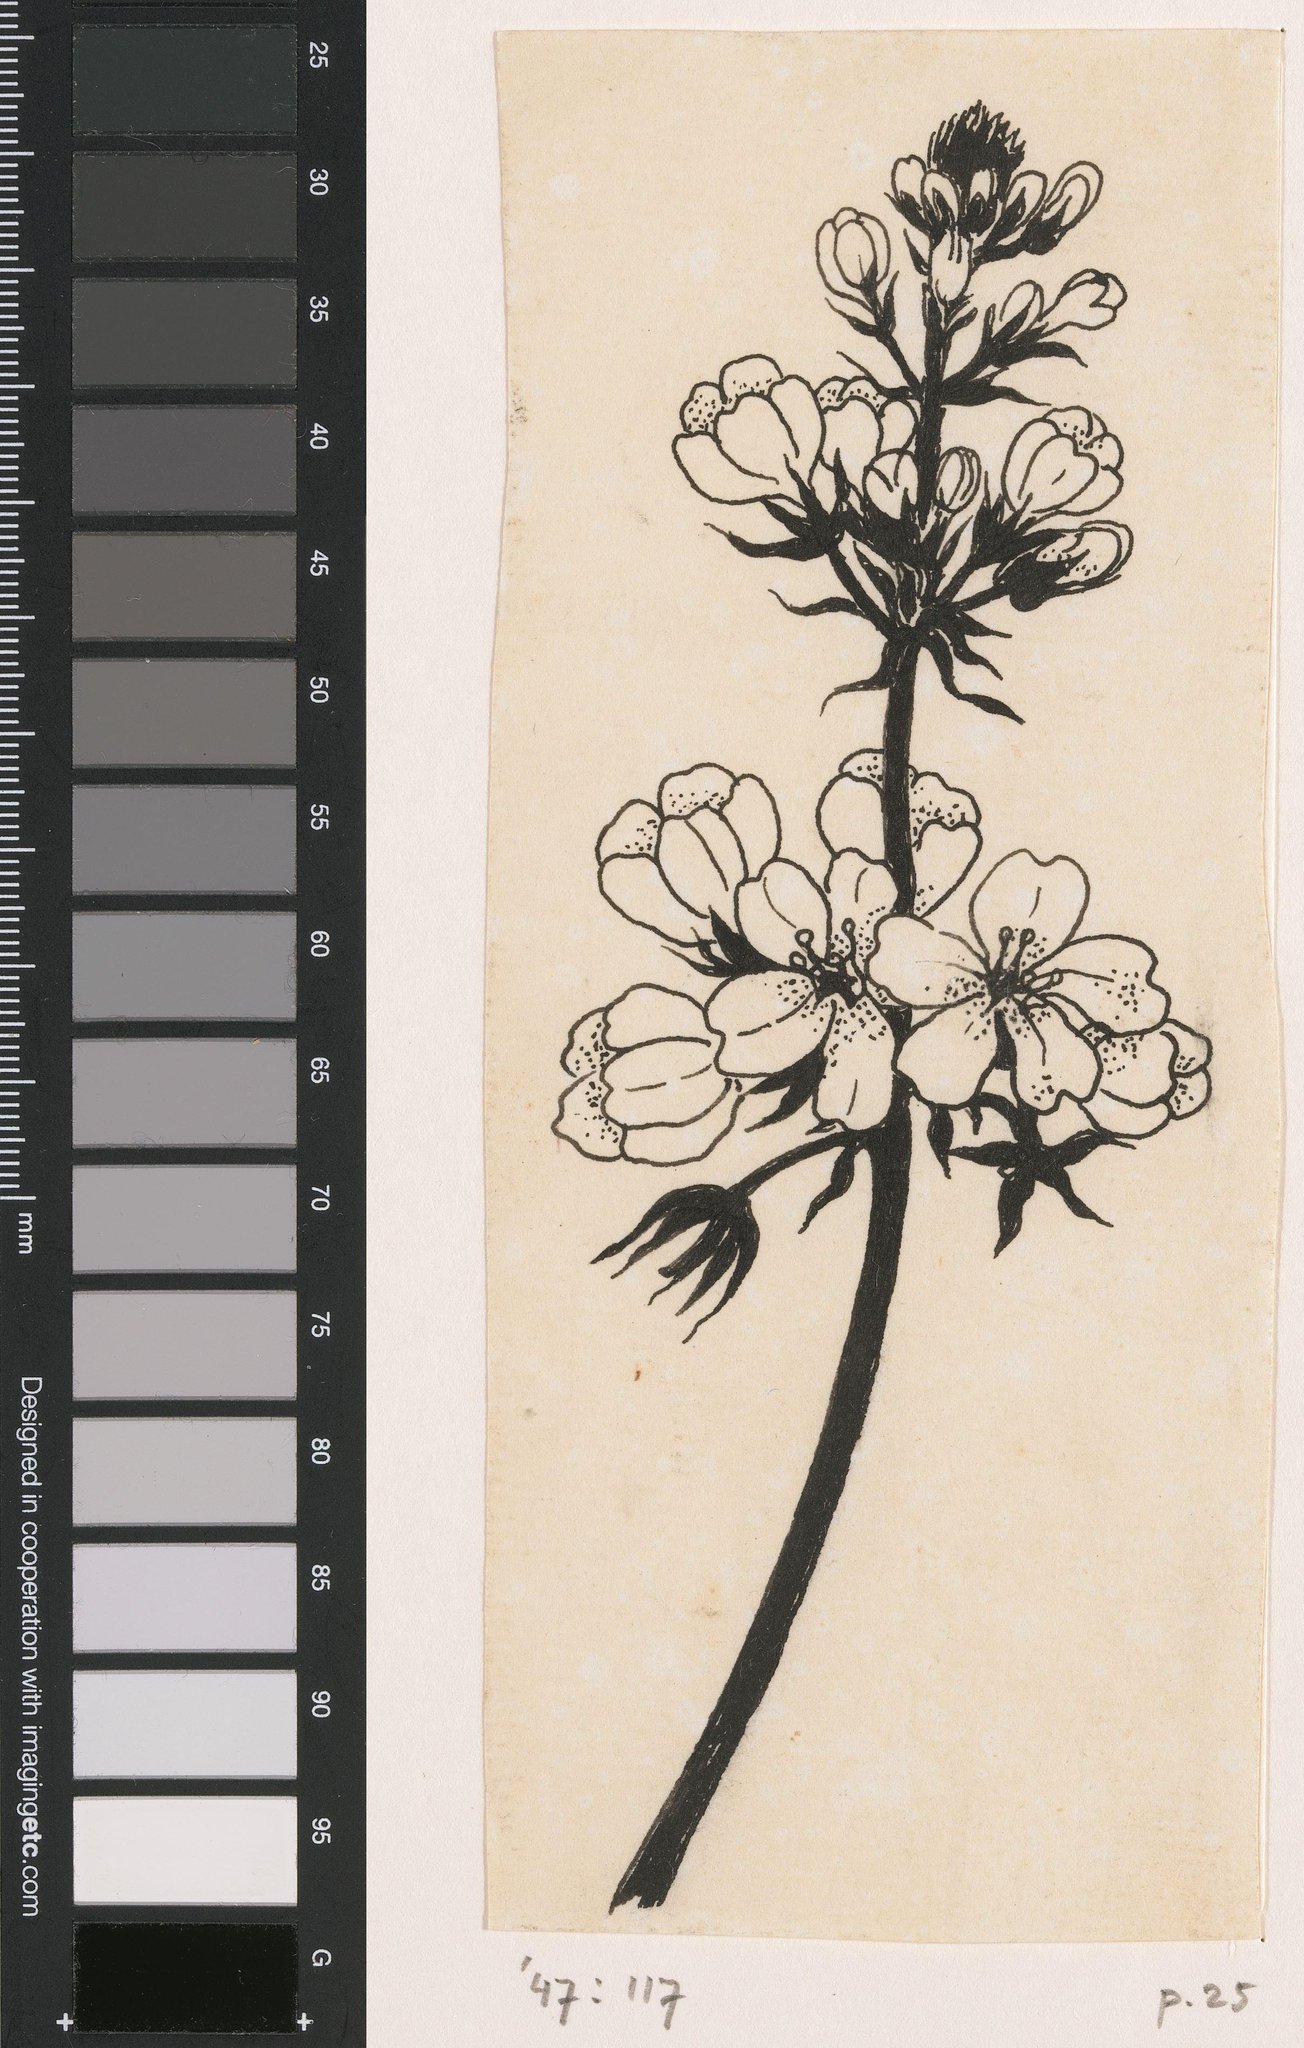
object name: drawing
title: Waterviolier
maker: willem wenckebach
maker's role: designer, draughtsman, painter, print maker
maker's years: 1860-1937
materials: ink, paper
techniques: pen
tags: plants (in general)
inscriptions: collector's mark: Lugt 2228a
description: Ontwerp voor: Knappert, Emilie C. Kijkjes in de plantenwereld. Loman & Funke: Amsterdam, 1893.